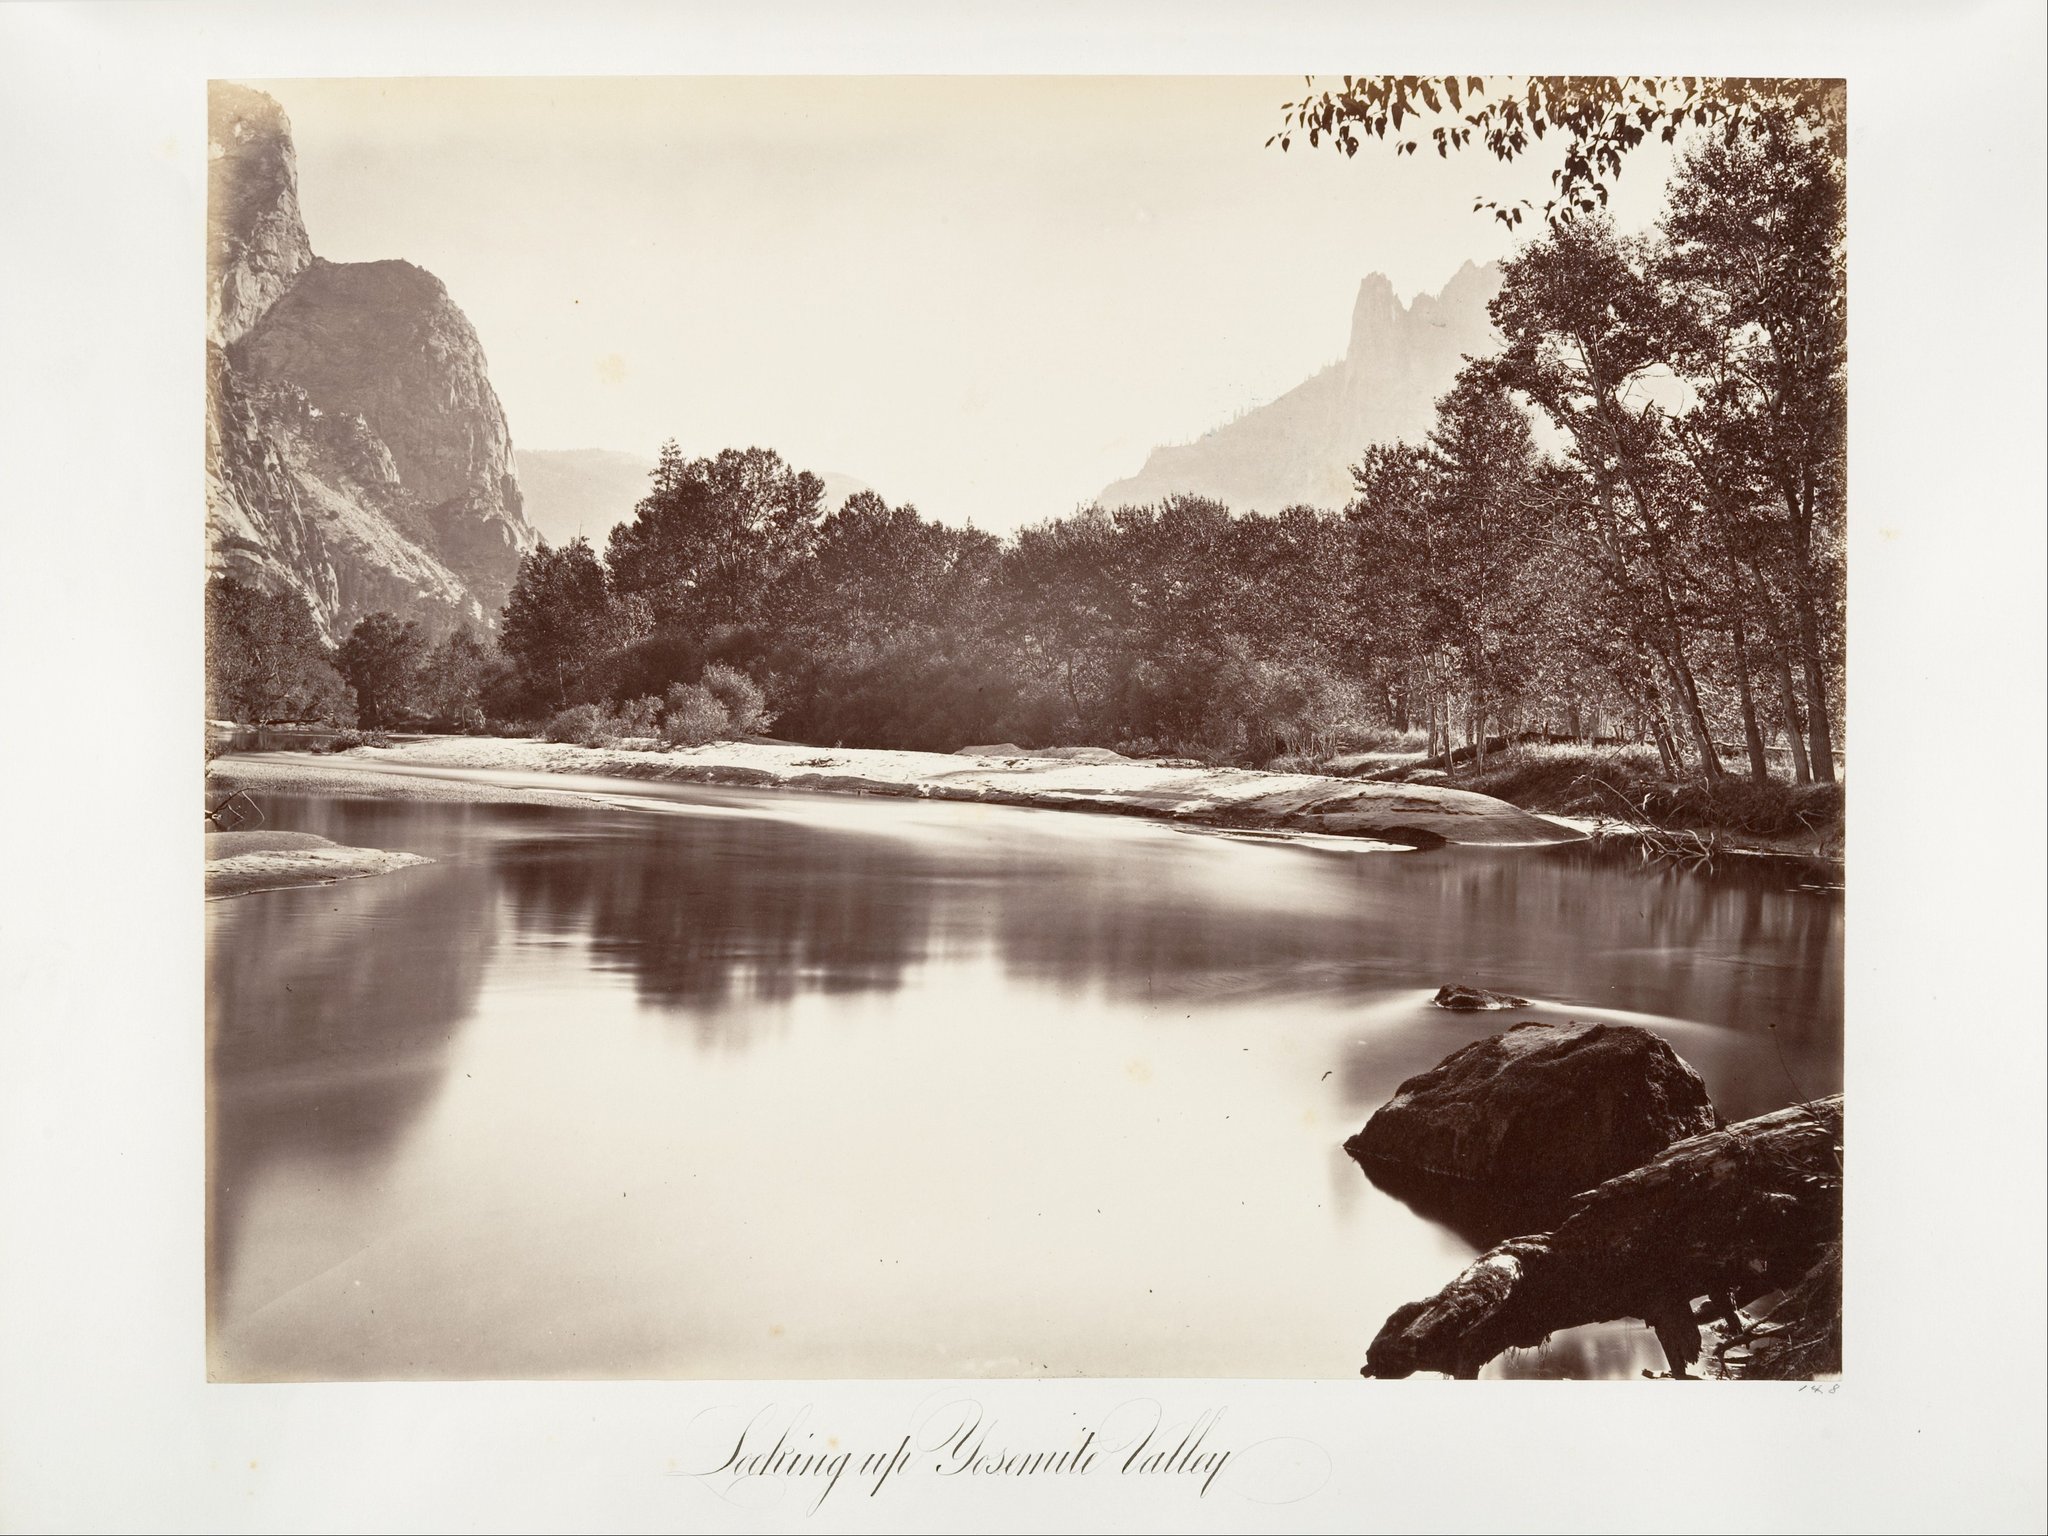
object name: photograph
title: Looking Up Yosemite Valley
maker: carleton e. watkins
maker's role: artist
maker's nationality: american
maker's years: 1829-1916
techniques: albumen silver print, glass negative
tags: landscapes